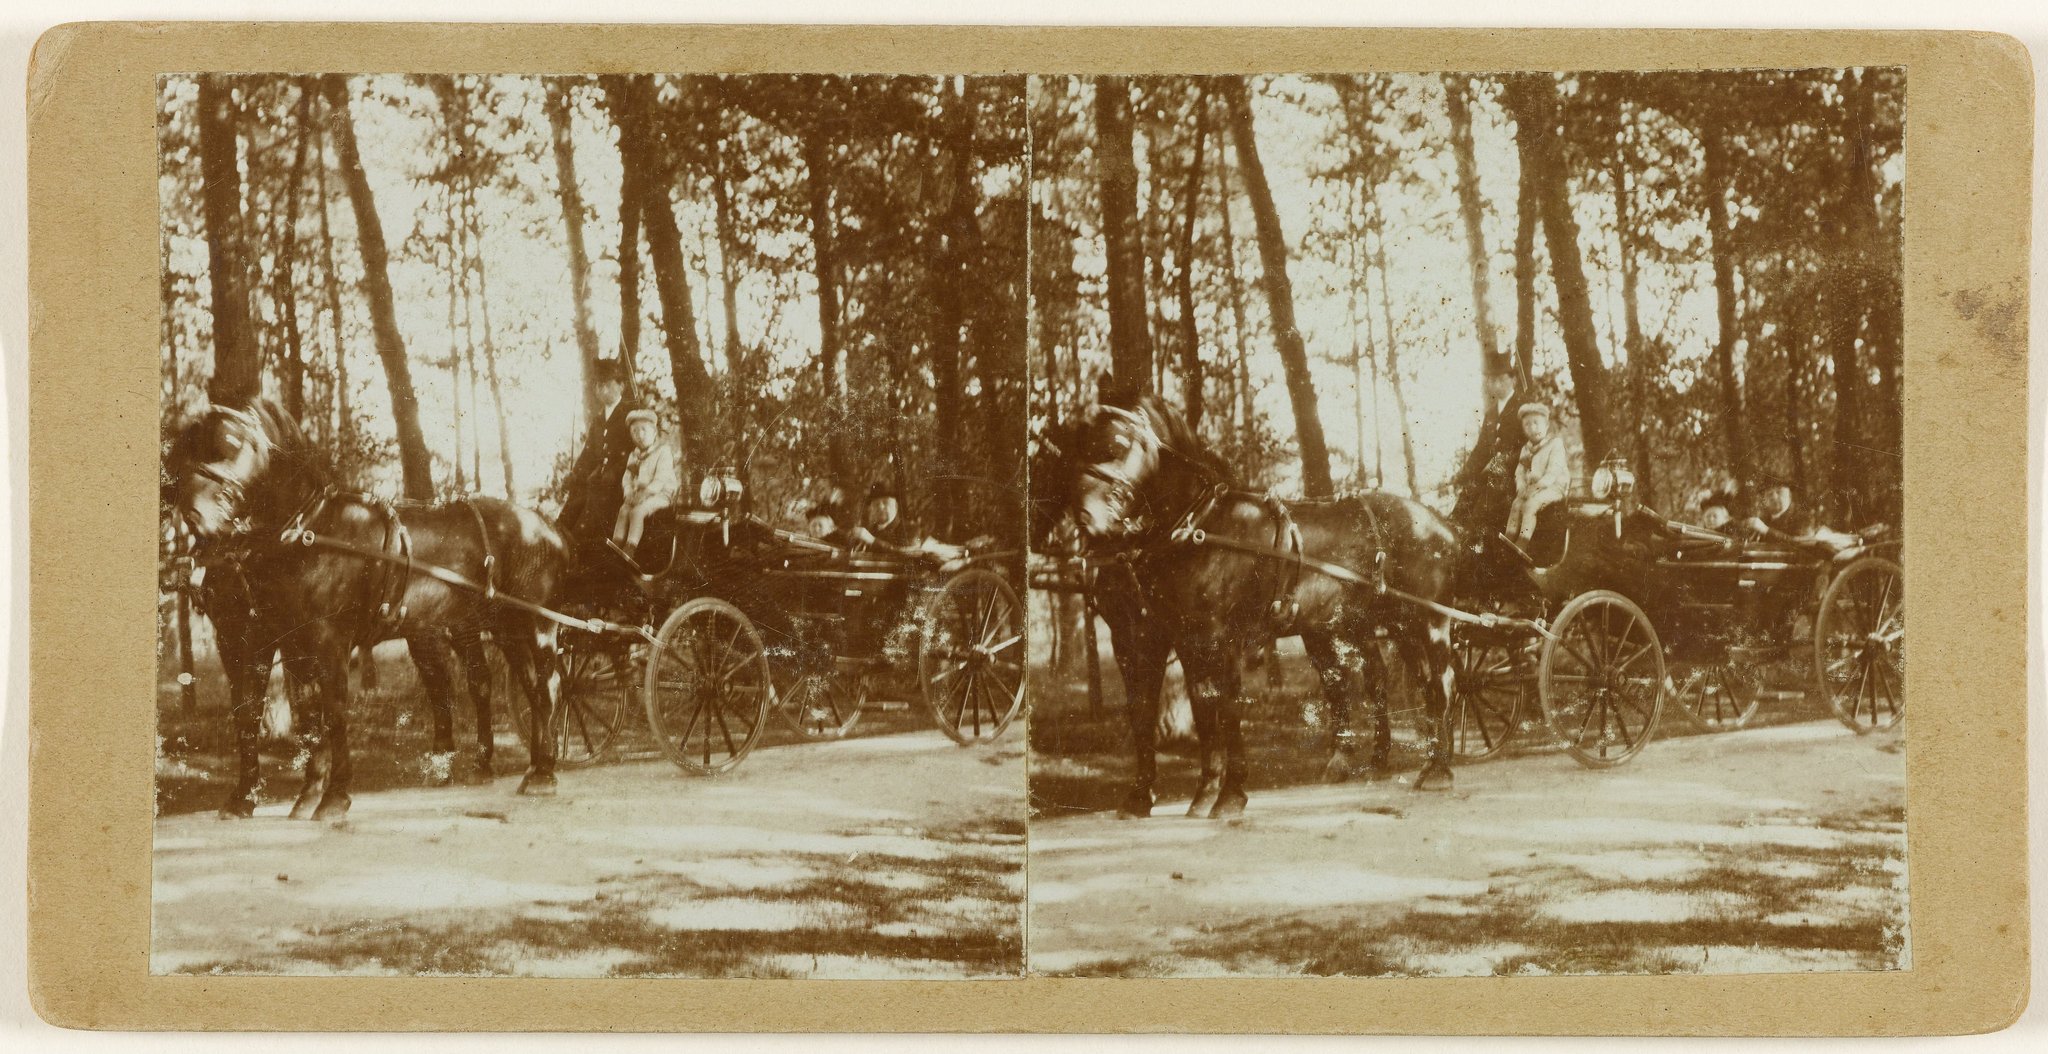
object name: stereograph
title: Het echtpaar Ten Cate in een rijtuig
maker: e. ten cate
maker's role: fotograaf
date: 1905-1910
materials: cardboard, photographic support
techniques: gelatin silver print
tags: four-wheeled vehicle drawn by two animals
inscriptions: annotation: ‘Ma en Pa ten Cate in t rijtuig // mei 1910’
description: Een dame en een heer in een rijtuig. Een jongetje naast de koetsier op de bok.